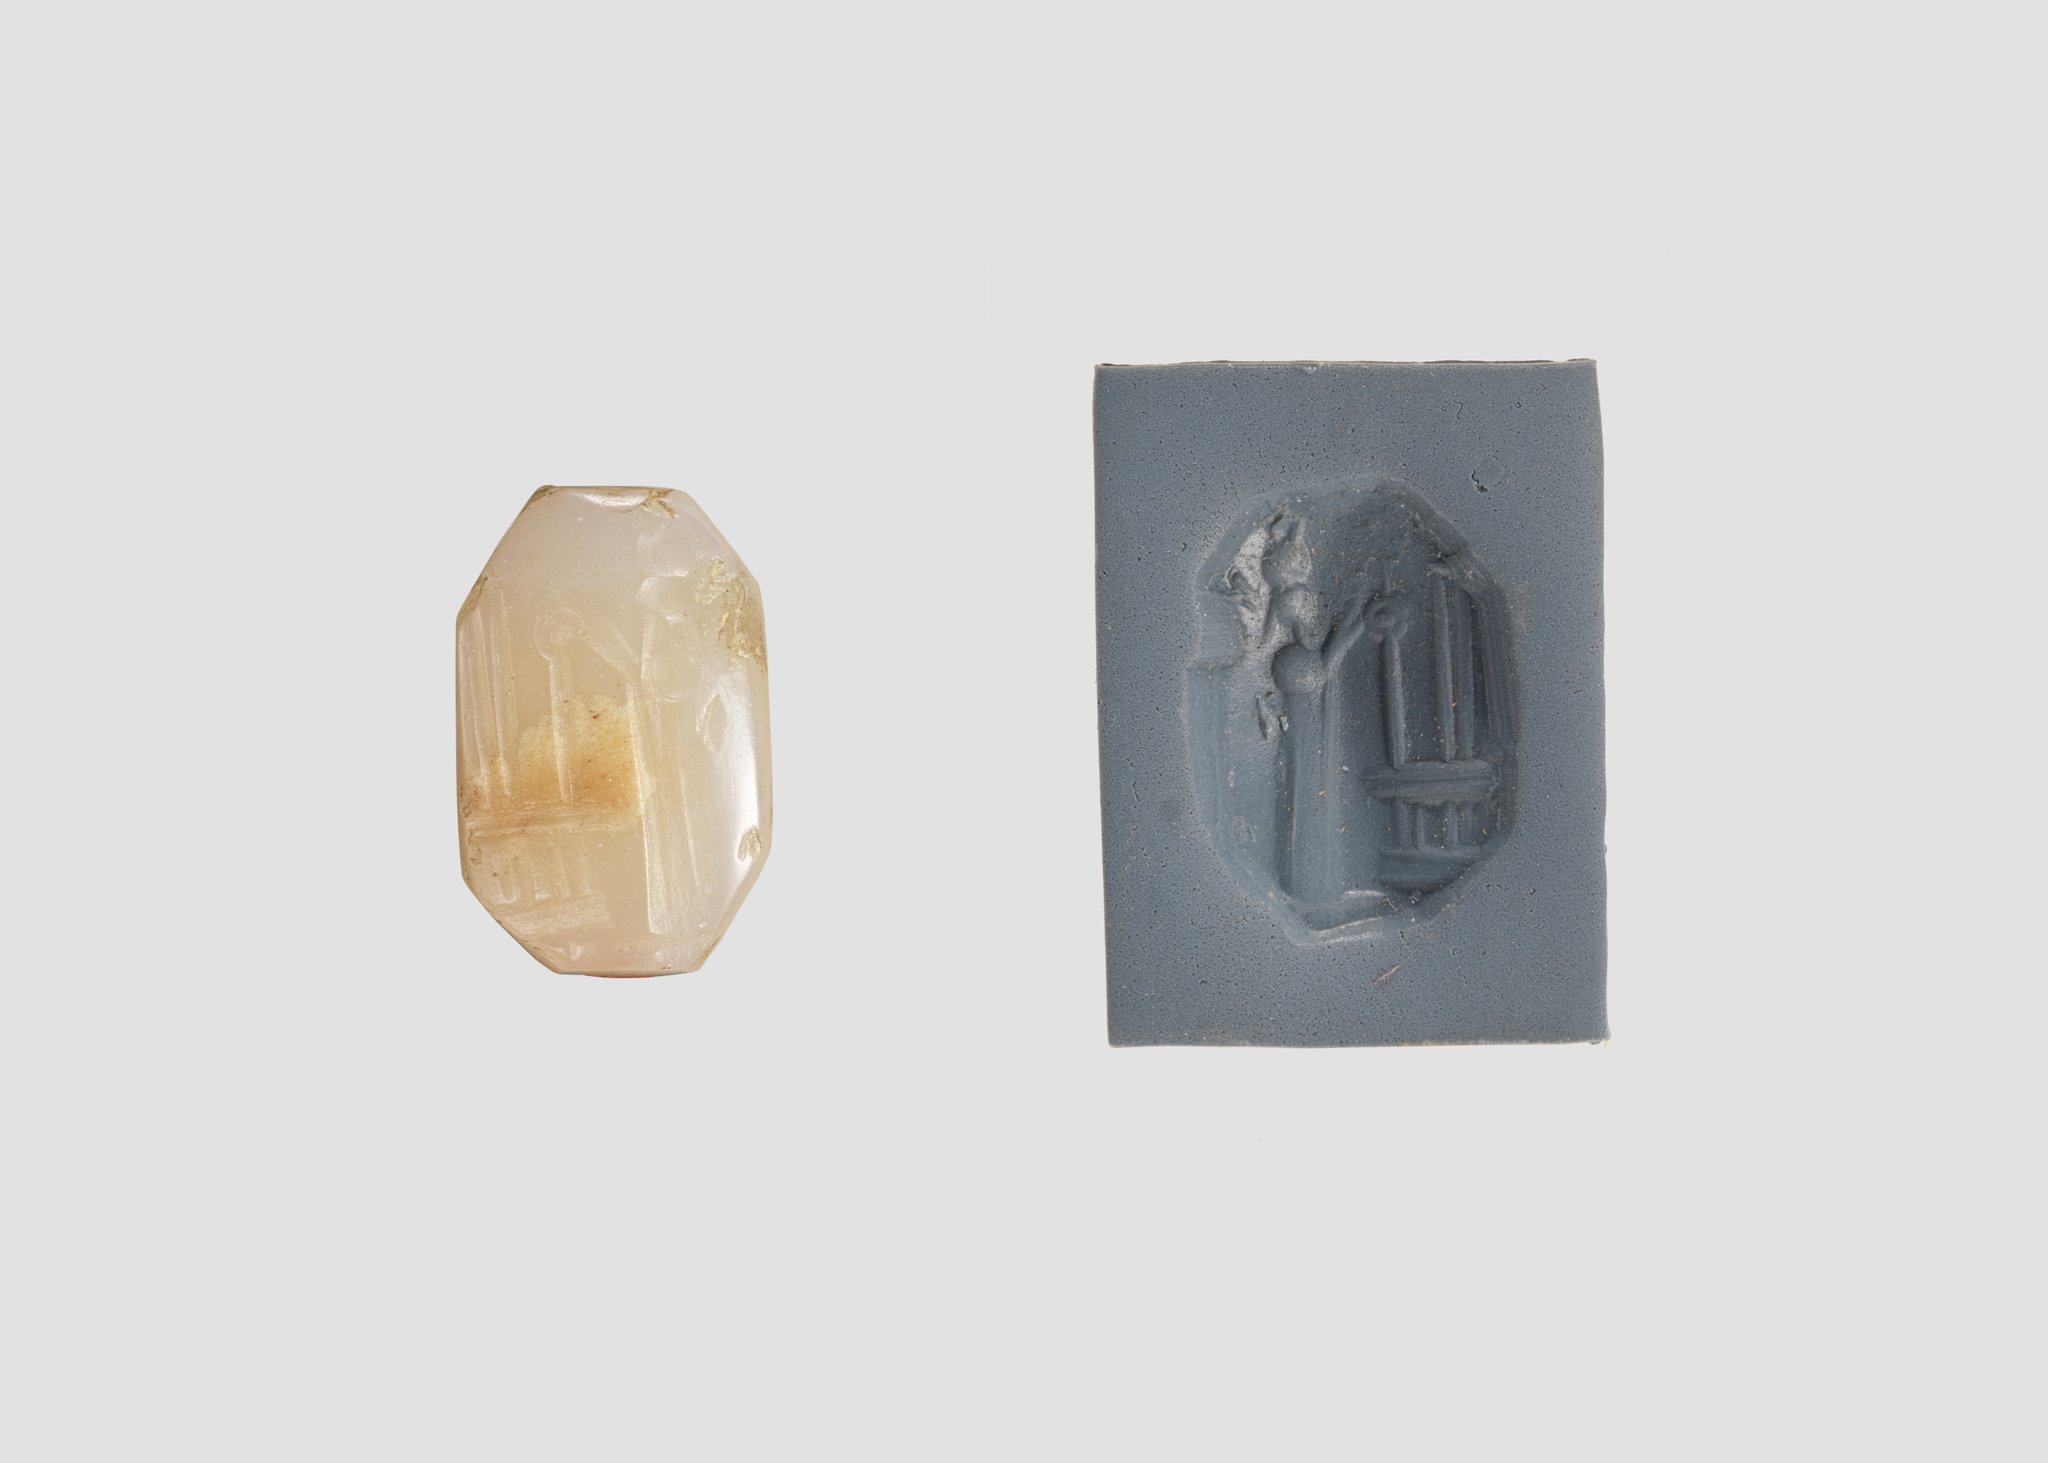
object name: stamp seal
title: Stamp seal (octagonal pyramid) with cultic scene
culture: assyro-babylonian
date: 700-501 BCE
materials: stone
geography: mesopotamia